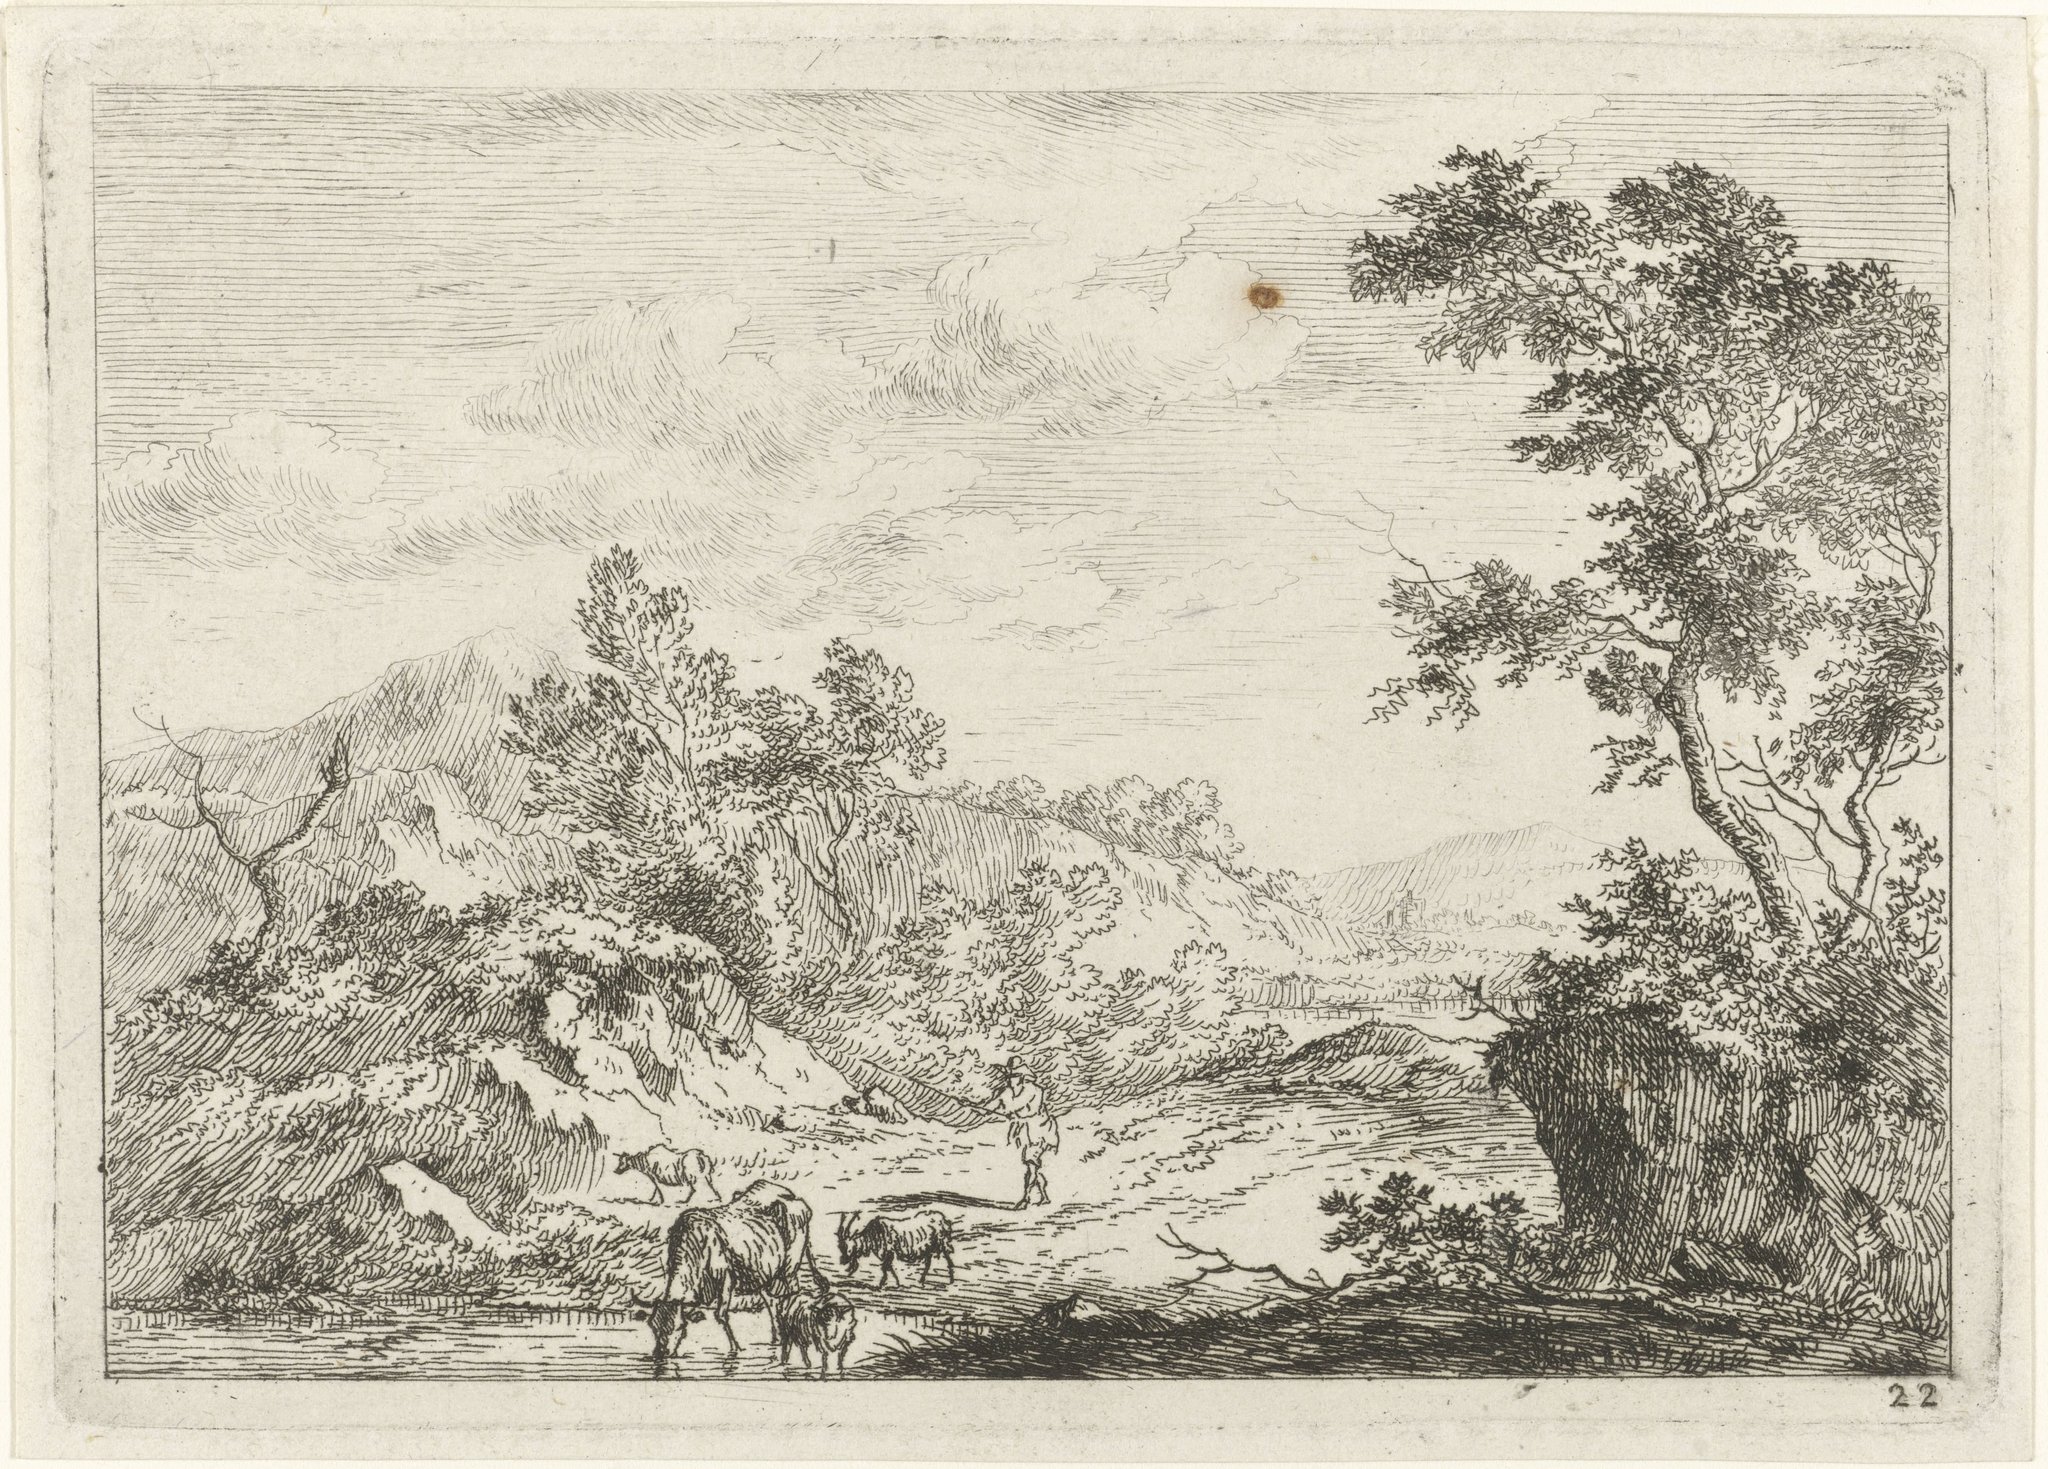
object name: print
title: Landschap met herder en vee bij beek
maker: johannes janson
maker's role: draughtsman, painter, print maker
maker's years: 1729-1784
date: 1761-1784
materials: paper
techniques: etching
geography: leiden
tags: herding, herdsman, herdswoman, shepherd, shepherdess, cowherd, etc., landscapes (+ landscape with figures, staffage)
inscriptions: collector's mark: Lugt 2228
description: Heuvelachtig landschap met een herder, die zijn vee naar een beekje drijft om te drinken. Rechtsonder: 22. Prent uit een serie met landschappen.